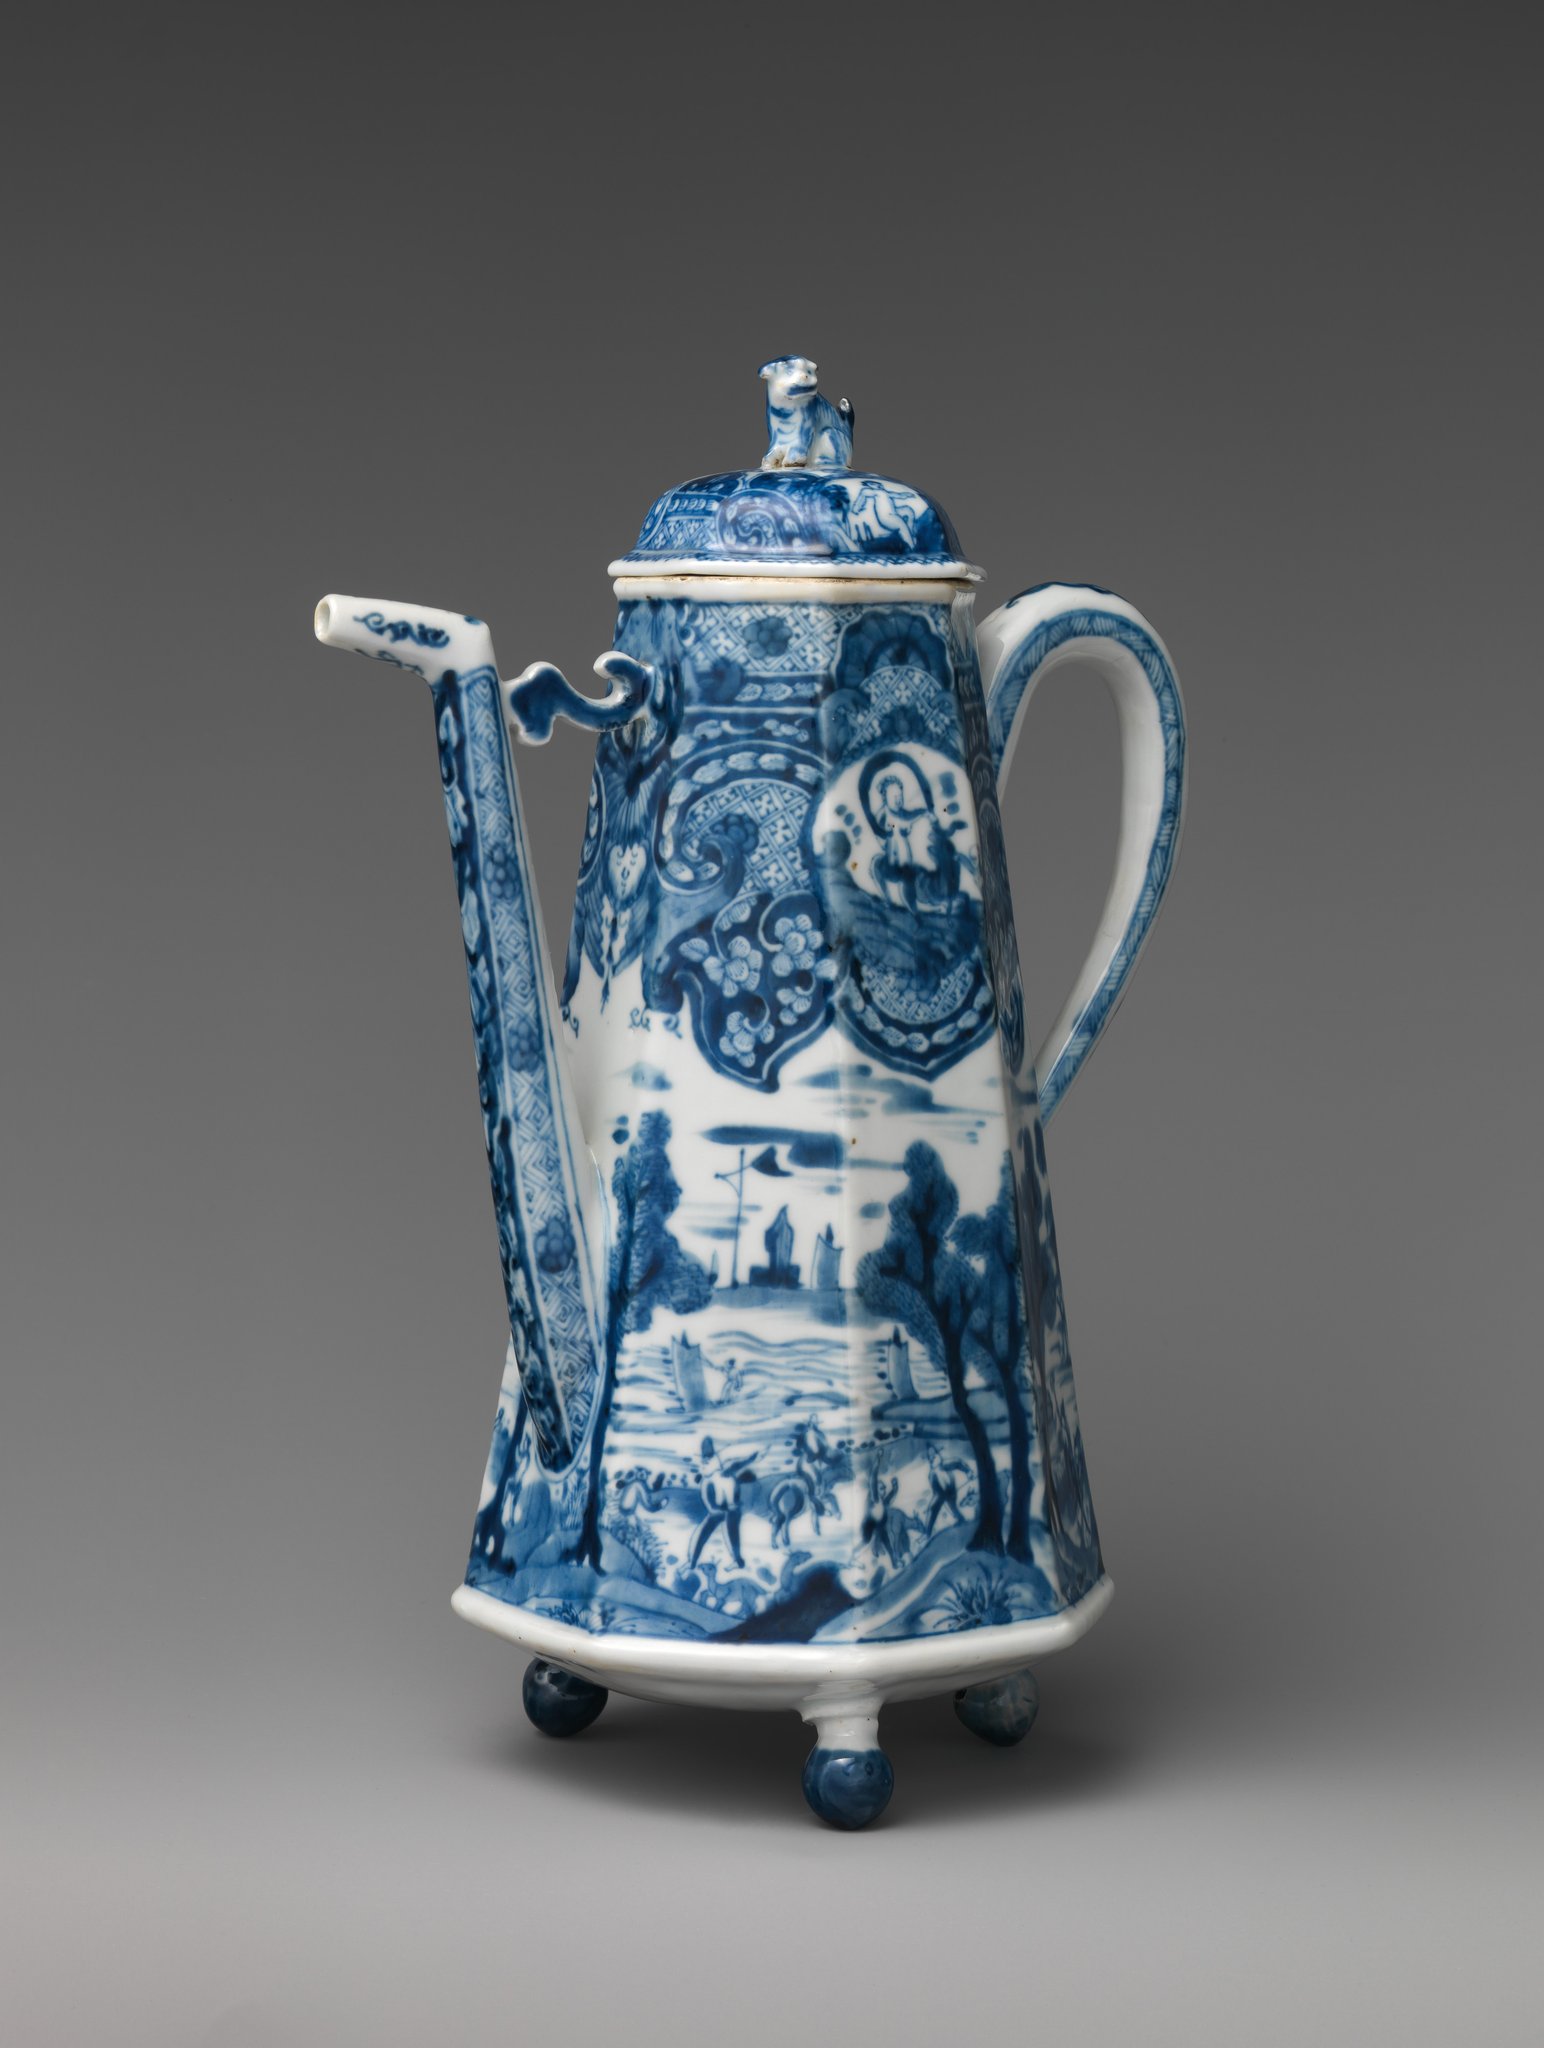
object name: coffeepot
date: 1710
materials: hard paste porcelain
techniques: underglaze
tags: animals,horses,trees,boats